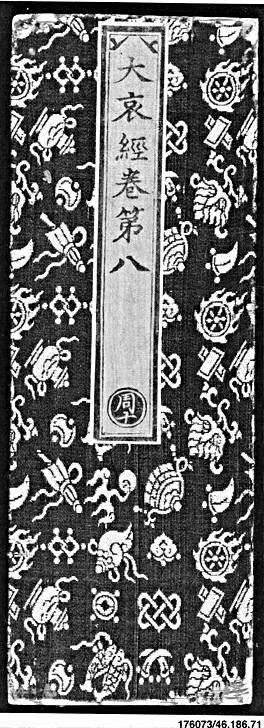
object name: sutra cover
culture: chinese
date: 1501-1600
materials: silk